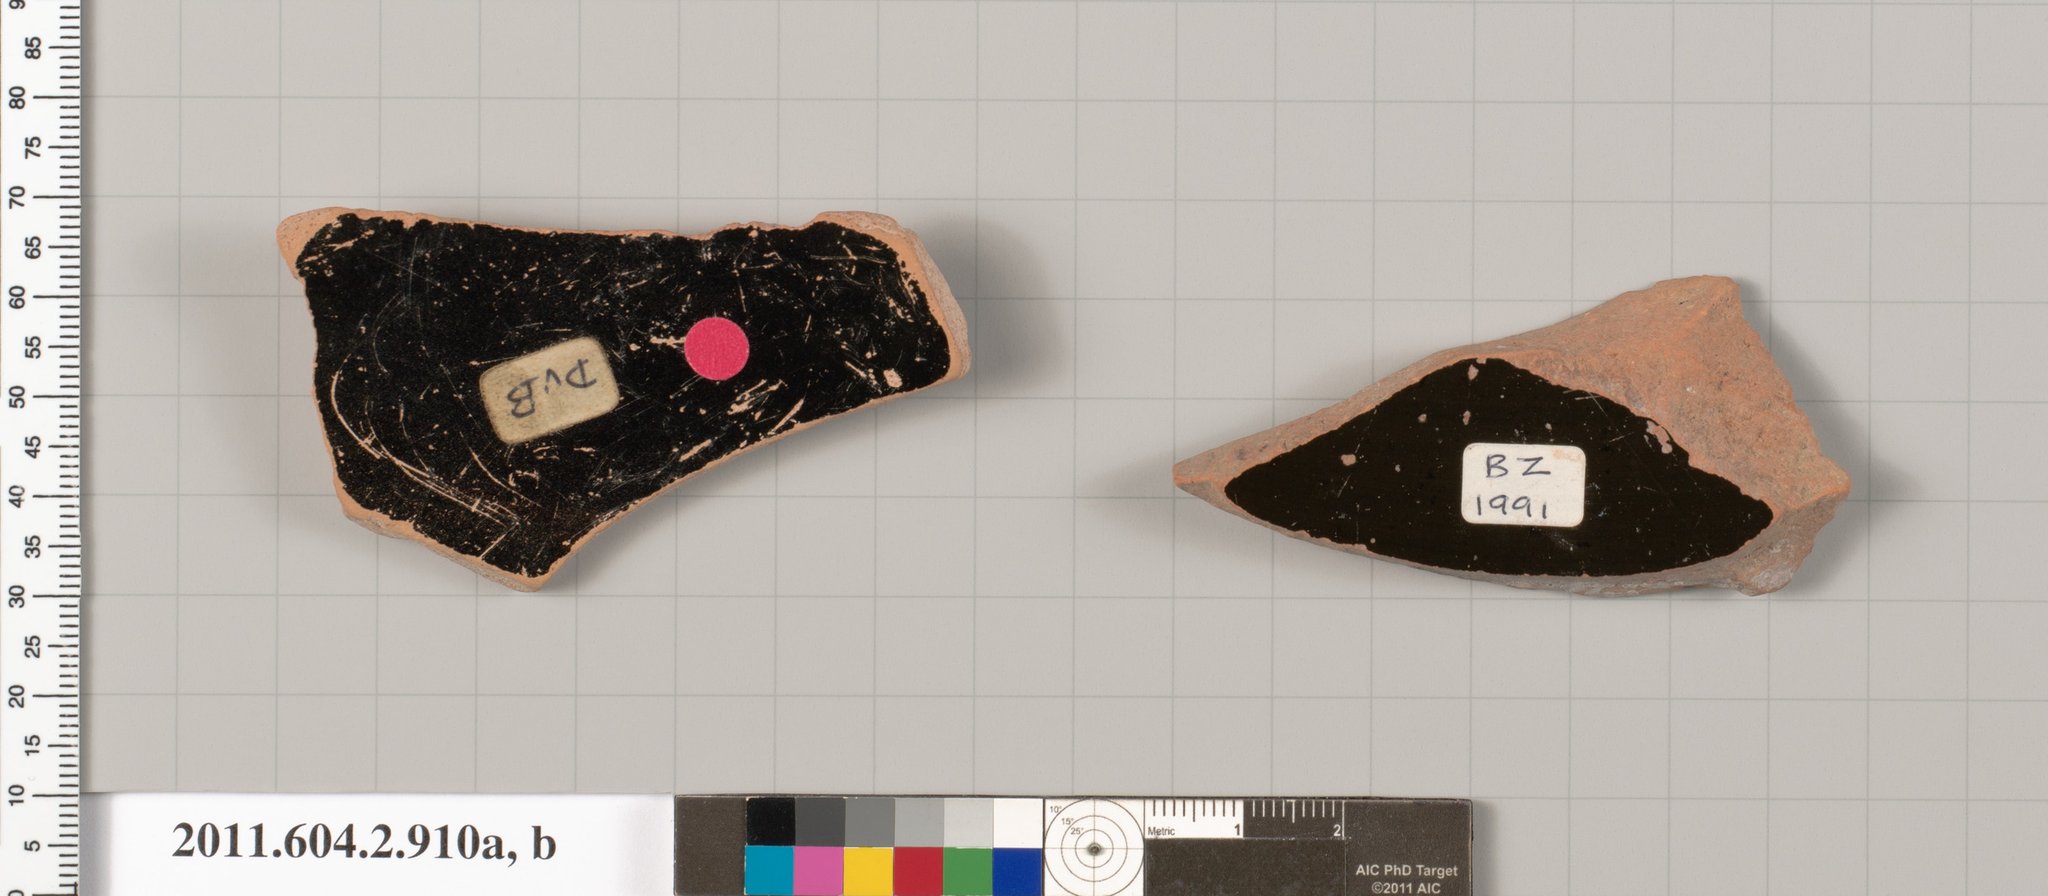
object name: bell krater fragment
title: Terracotta fragments of bell-kraters (bowls for mixing wine and water)?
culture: greek, attic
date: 450-401 BCE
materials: terracotta